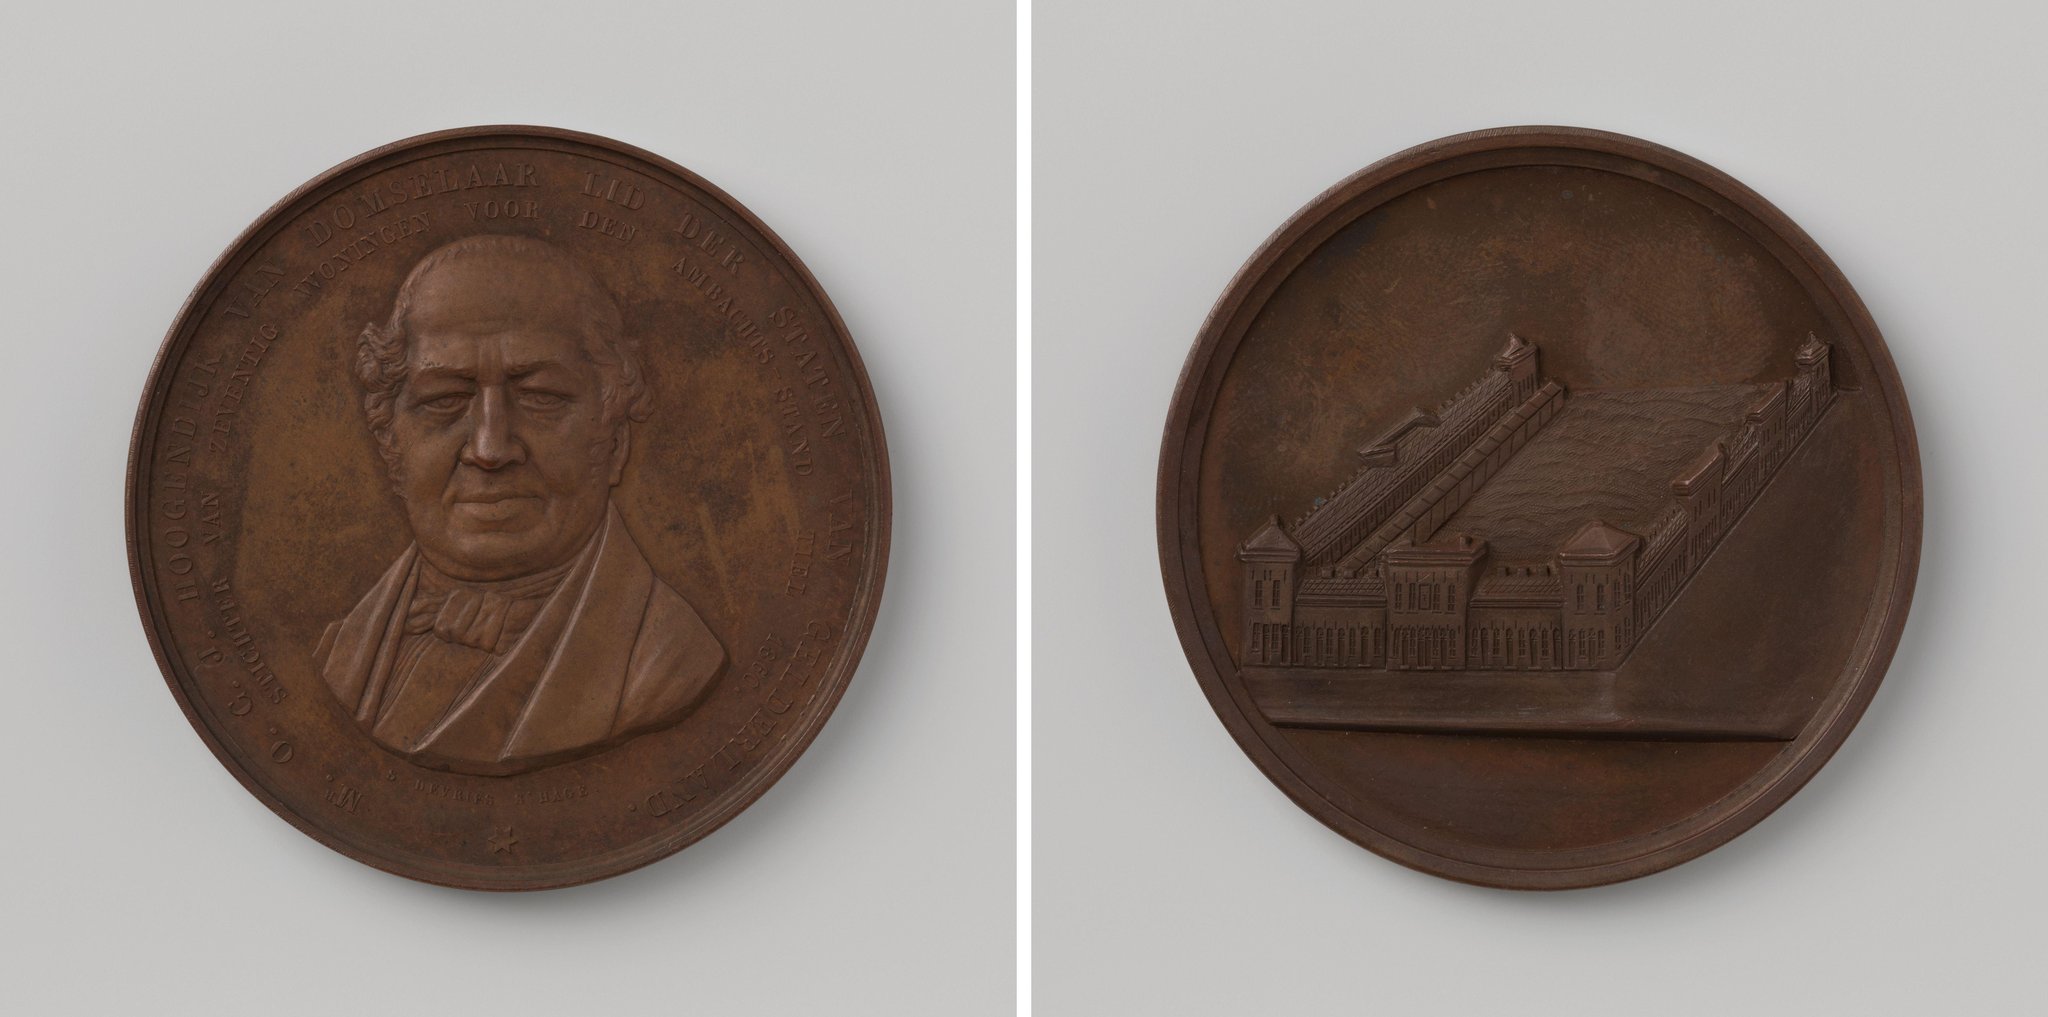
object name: honorary medal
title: O.C.J. Hoogendijk van Domselaar, lid van de Staten van Gelderland, stichter van zeventig huizen voor ambachtslieden te Tiel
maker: salomon de vries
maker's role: graveur, medailleur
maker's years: 1830-1899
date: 1860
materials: bronze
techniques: striking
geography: the hague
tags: o.c.j. hoogendijk van domselaar, staten van gelderland, tiel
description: Bronzen penning. Voorzijde: borststuk man binnen tweeregelig omschrift. Keerzijde: huizenblok